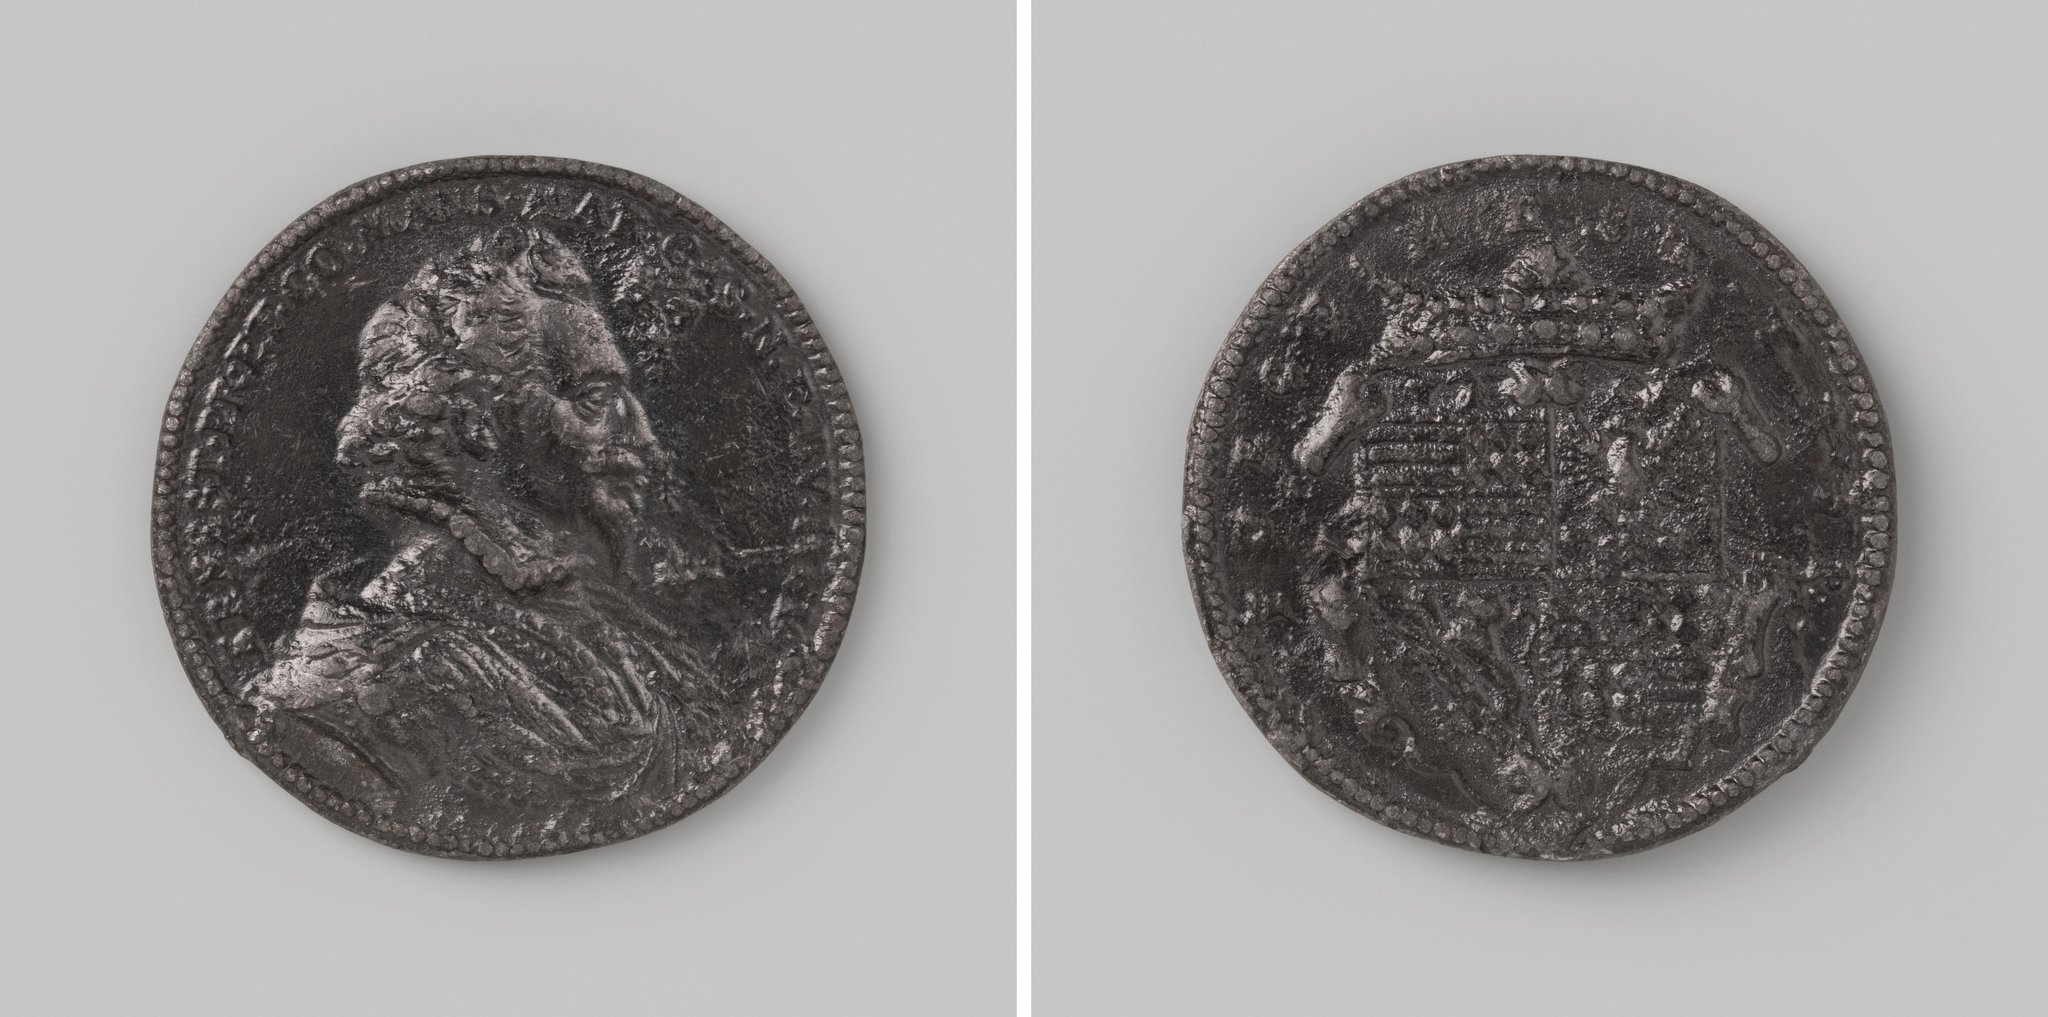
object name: history medal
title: Ernst van Mansveld (1622)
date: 1592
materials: tin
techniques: casting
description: Ronde tinnen penning, op de voorzijde het borstbeeld van Ernst van Mansfeld naar rechts met omschrift, op de keerzijde een gekroond wapenschild met omschrift.